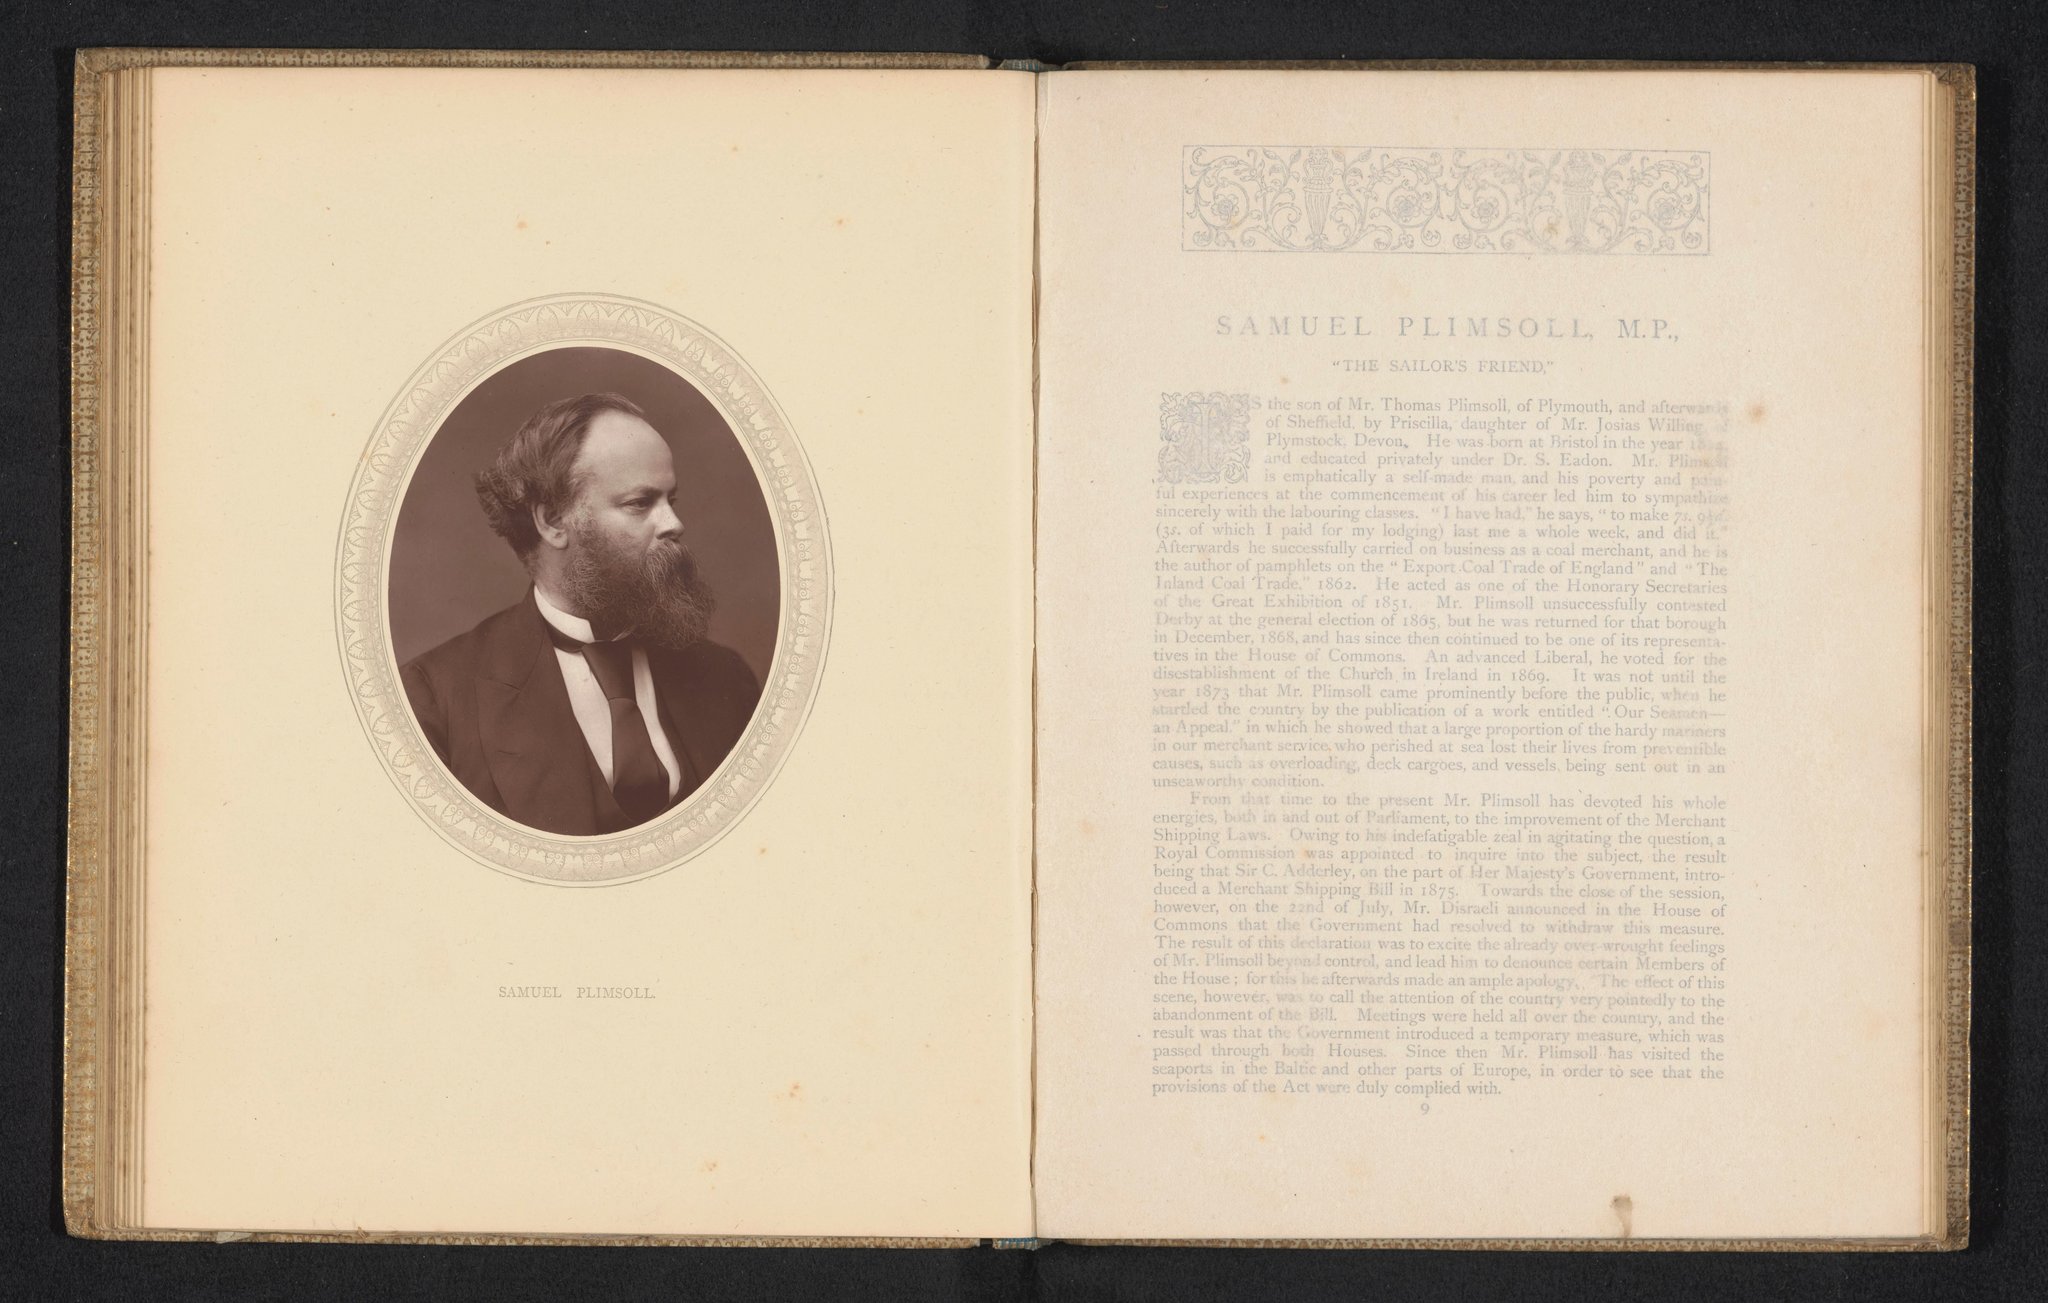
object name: page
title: Samuel Plimsoll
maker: Anonymous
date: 1871-1876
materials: paper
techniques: woodburytype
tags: politician, historical persons (portraits and scenes from the life) (+ (full) bust portrait), politician, e.g. party leader